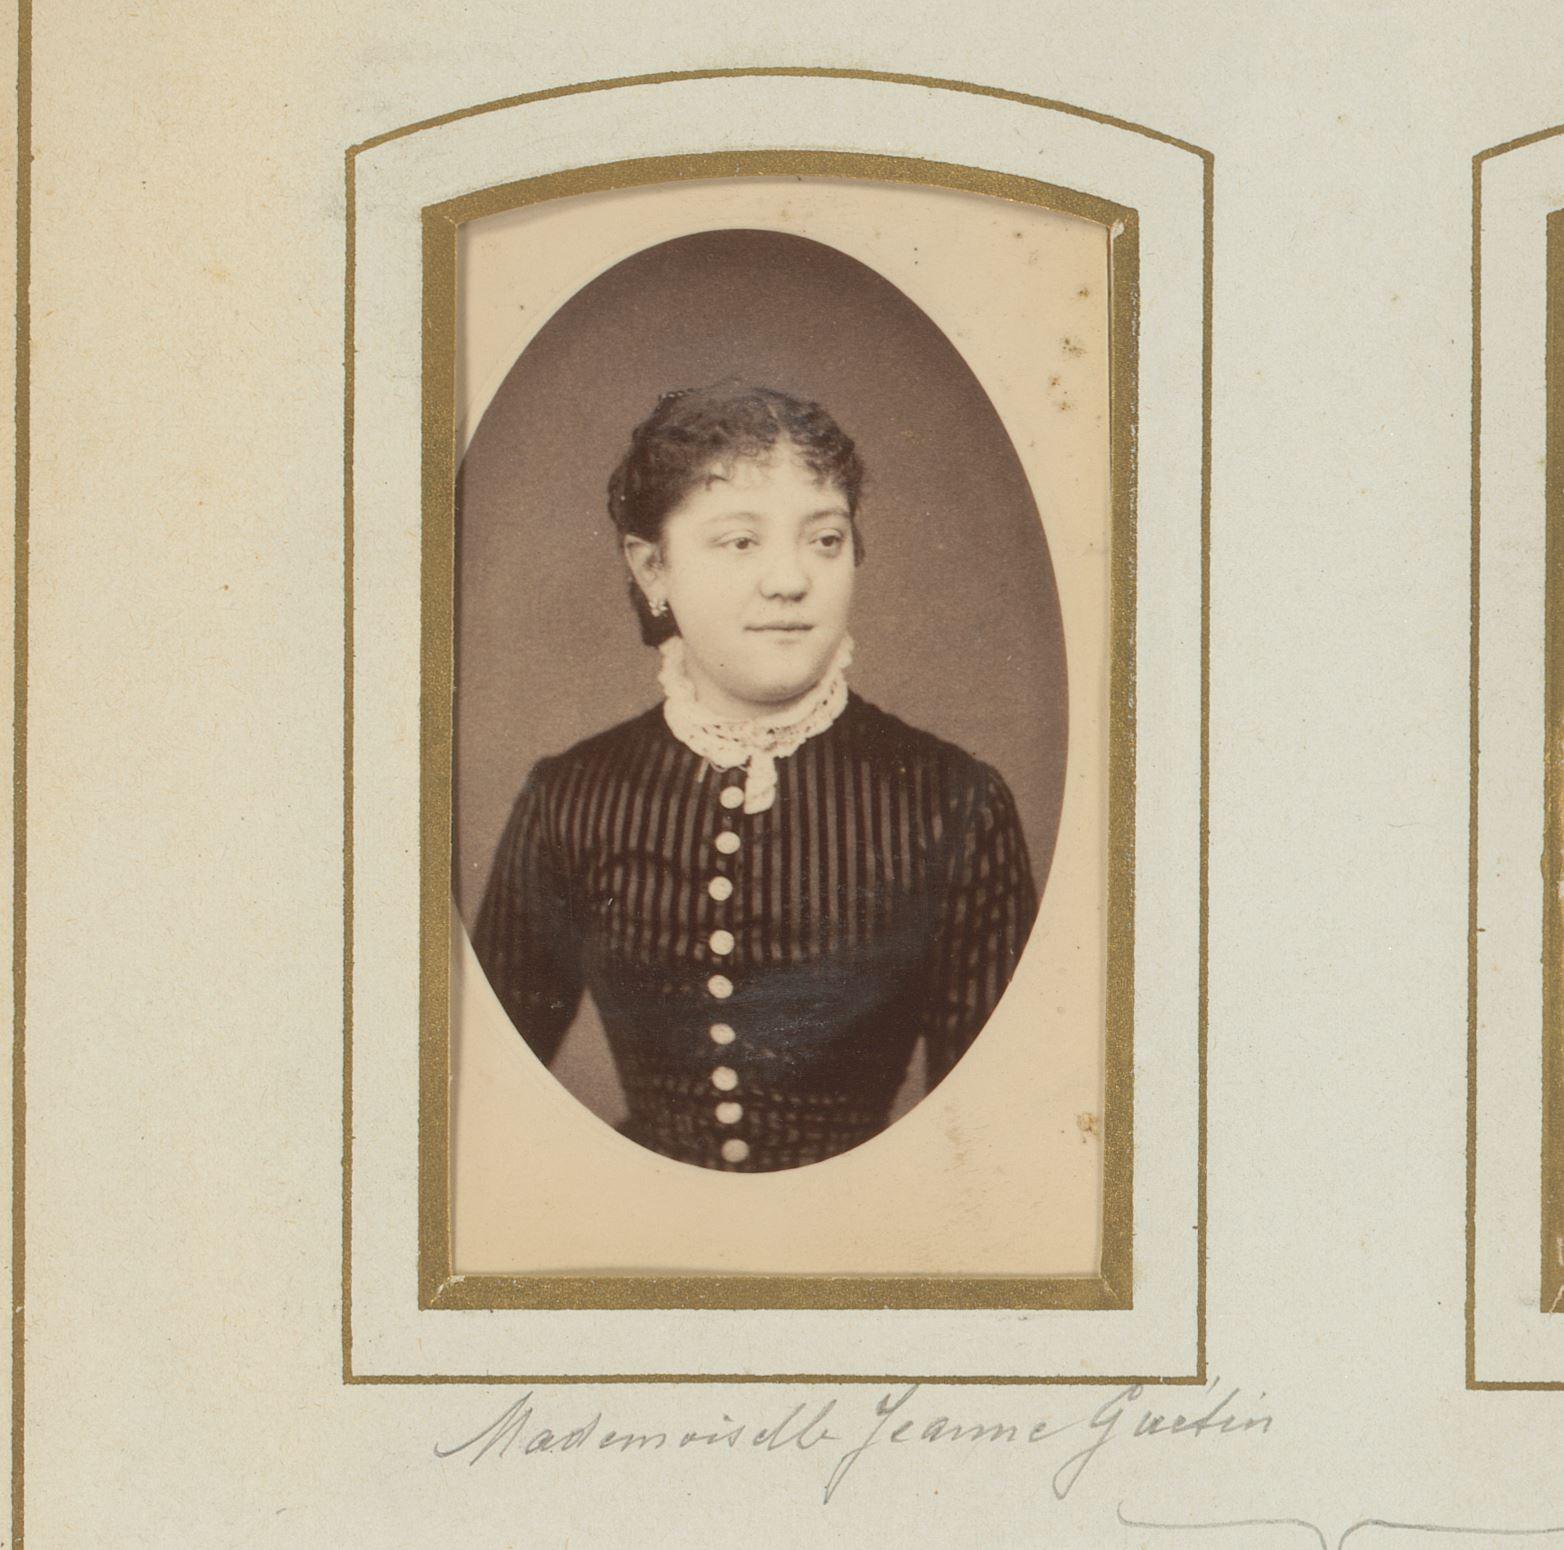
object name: semi enamel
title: Portret van Jeanne Guétin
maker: jean théodore jamin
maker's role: fotograaf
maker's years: -1867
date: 1880-1900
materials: cardboard, celluloid, photographic support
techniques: albumen print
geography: paris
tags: historical persons - bb - woman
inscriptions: inscription: ‘PHOTOGRAPHIE/ JAMIN/ (Bte S.G.D.G.)/ 13, Rue Chapon 13,/ HÔTEL DE MONTBRISON/ Paris’